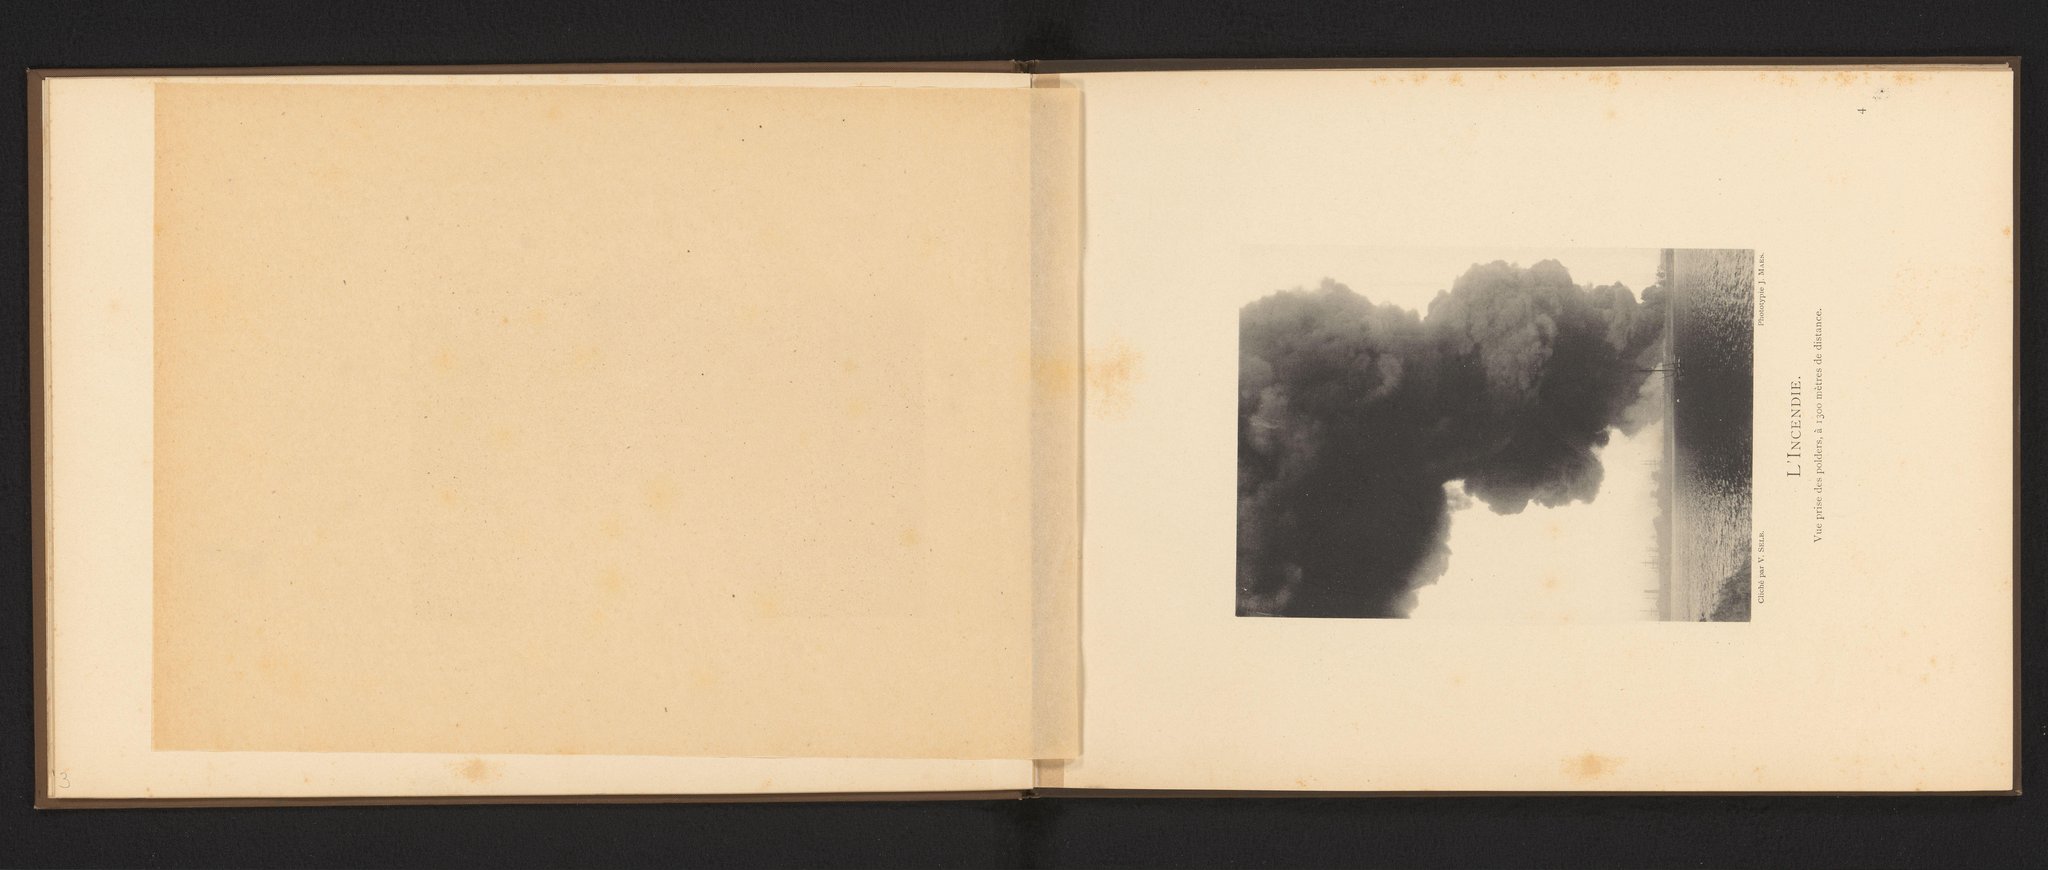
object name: page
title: L'incendie. Vue prise des polders, à 1300 mètres de distance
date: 1889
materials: paper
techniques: photograph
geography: oosterweel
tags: smoke, open fire (in general)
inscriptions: number: ‘4’